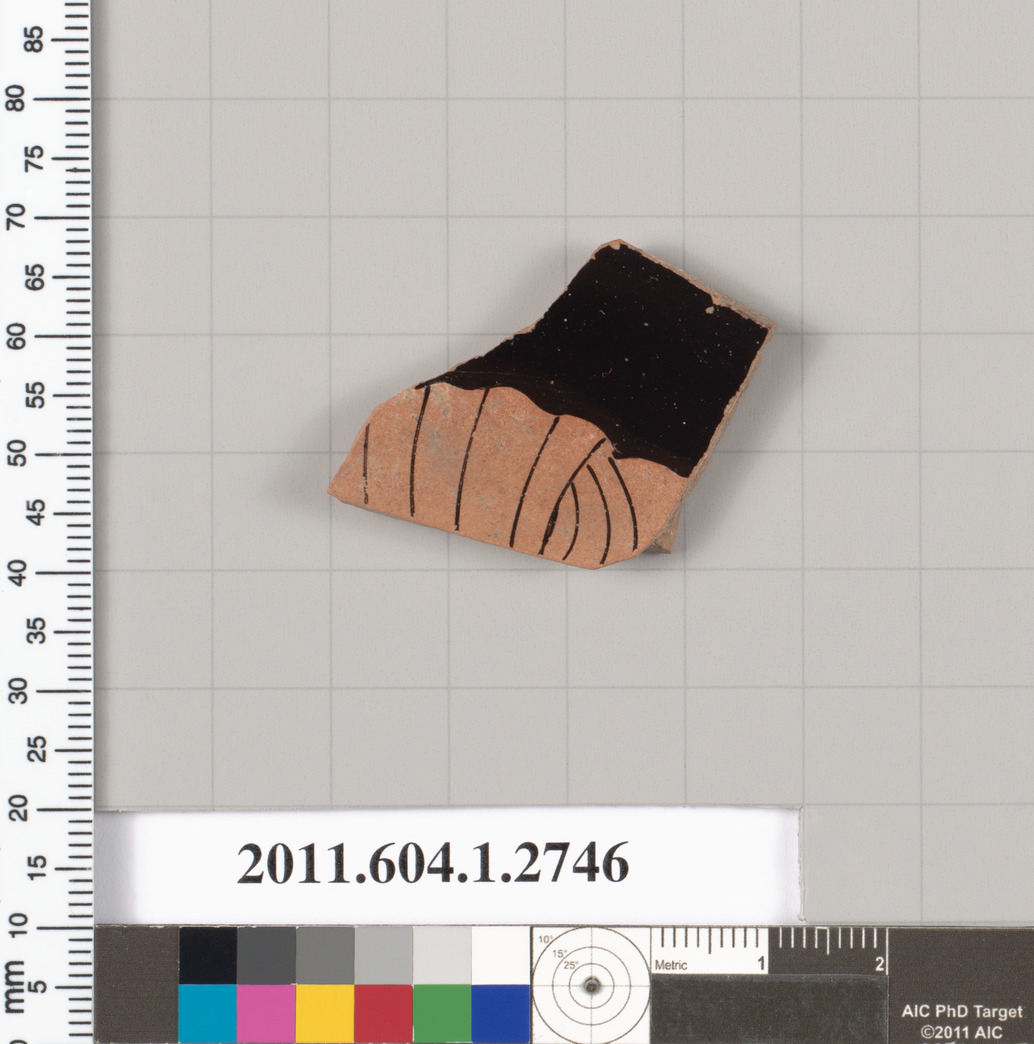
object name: kylix fragment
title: Terracotta fragment of a kylix (drinking cup)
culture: greek, attic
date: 490-480 BCE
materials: terracotta